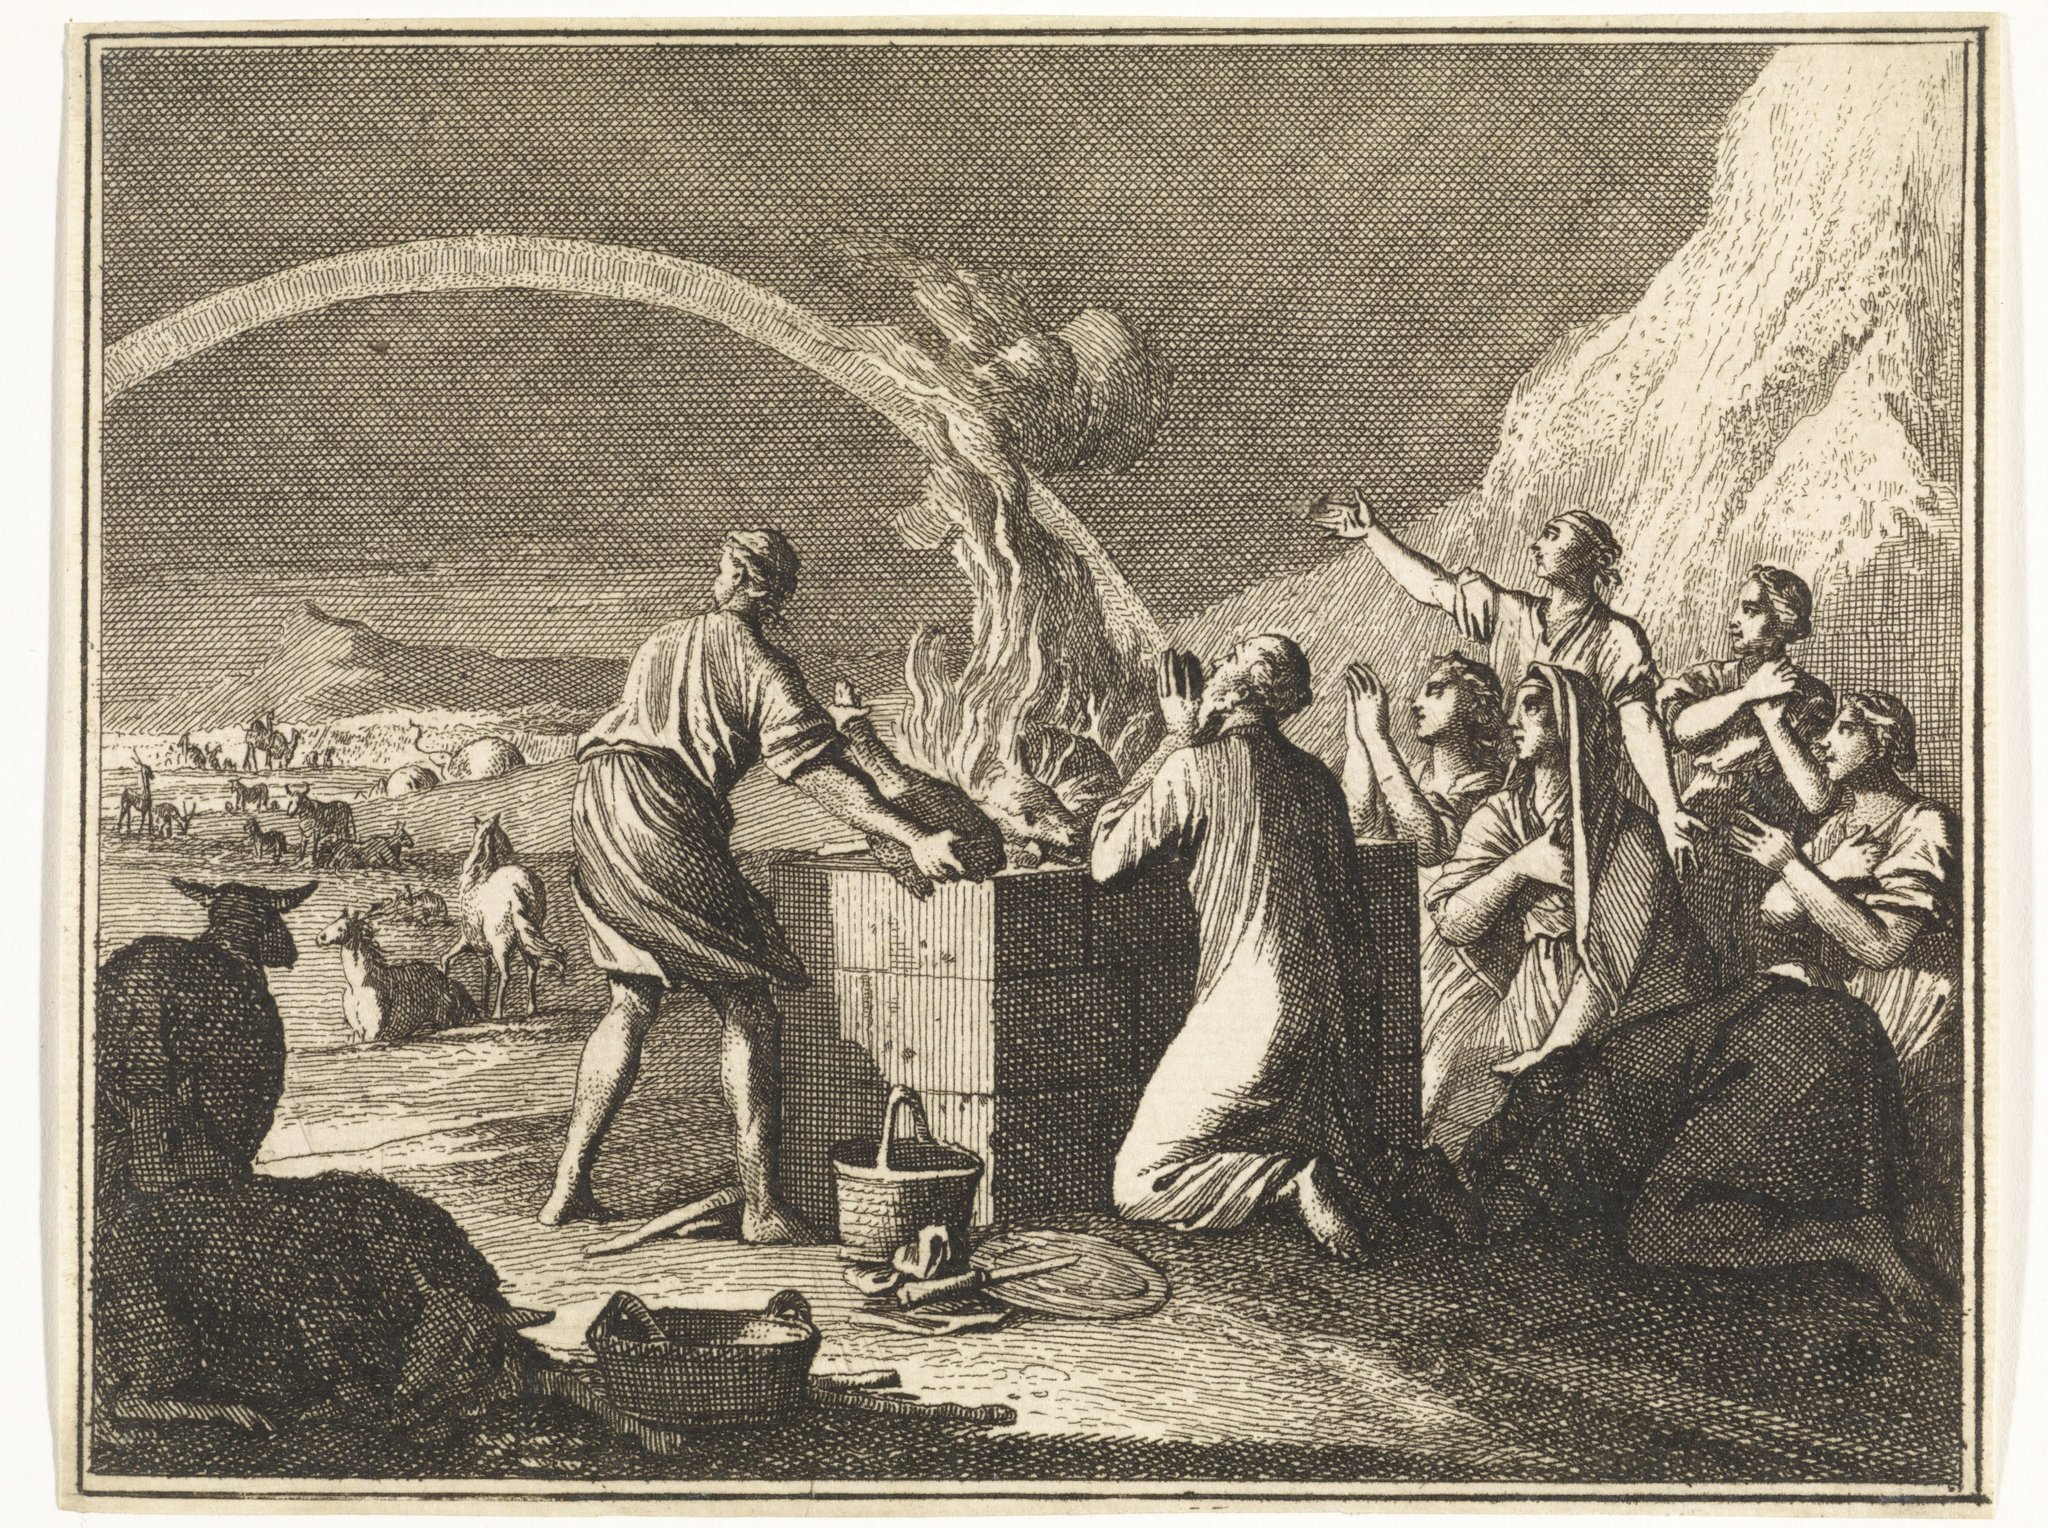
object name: print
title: Offer van Noach na de zondvloed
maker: caspar luyken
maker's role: draughtsman, print maker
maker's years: 1672-1708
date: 1712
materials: paper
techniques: etching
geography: amsterdam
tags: noah's sacrifice; various animals are offered, possibly a lamb, a dove and a ram (often combined with the rainbow of the covenant)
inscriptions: number: ‘15’, collector's mark: Lugt 2228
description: Illustratie uit: Luyken, Jan. De schriftuurlyke geschiedenissen en gelykenissen van het Oude en Nieuwe Verbond, 2 delen. Amsterdam: Wed. Pieter Arentsz II en Cornelis van der Sys, 1712, dl. I.